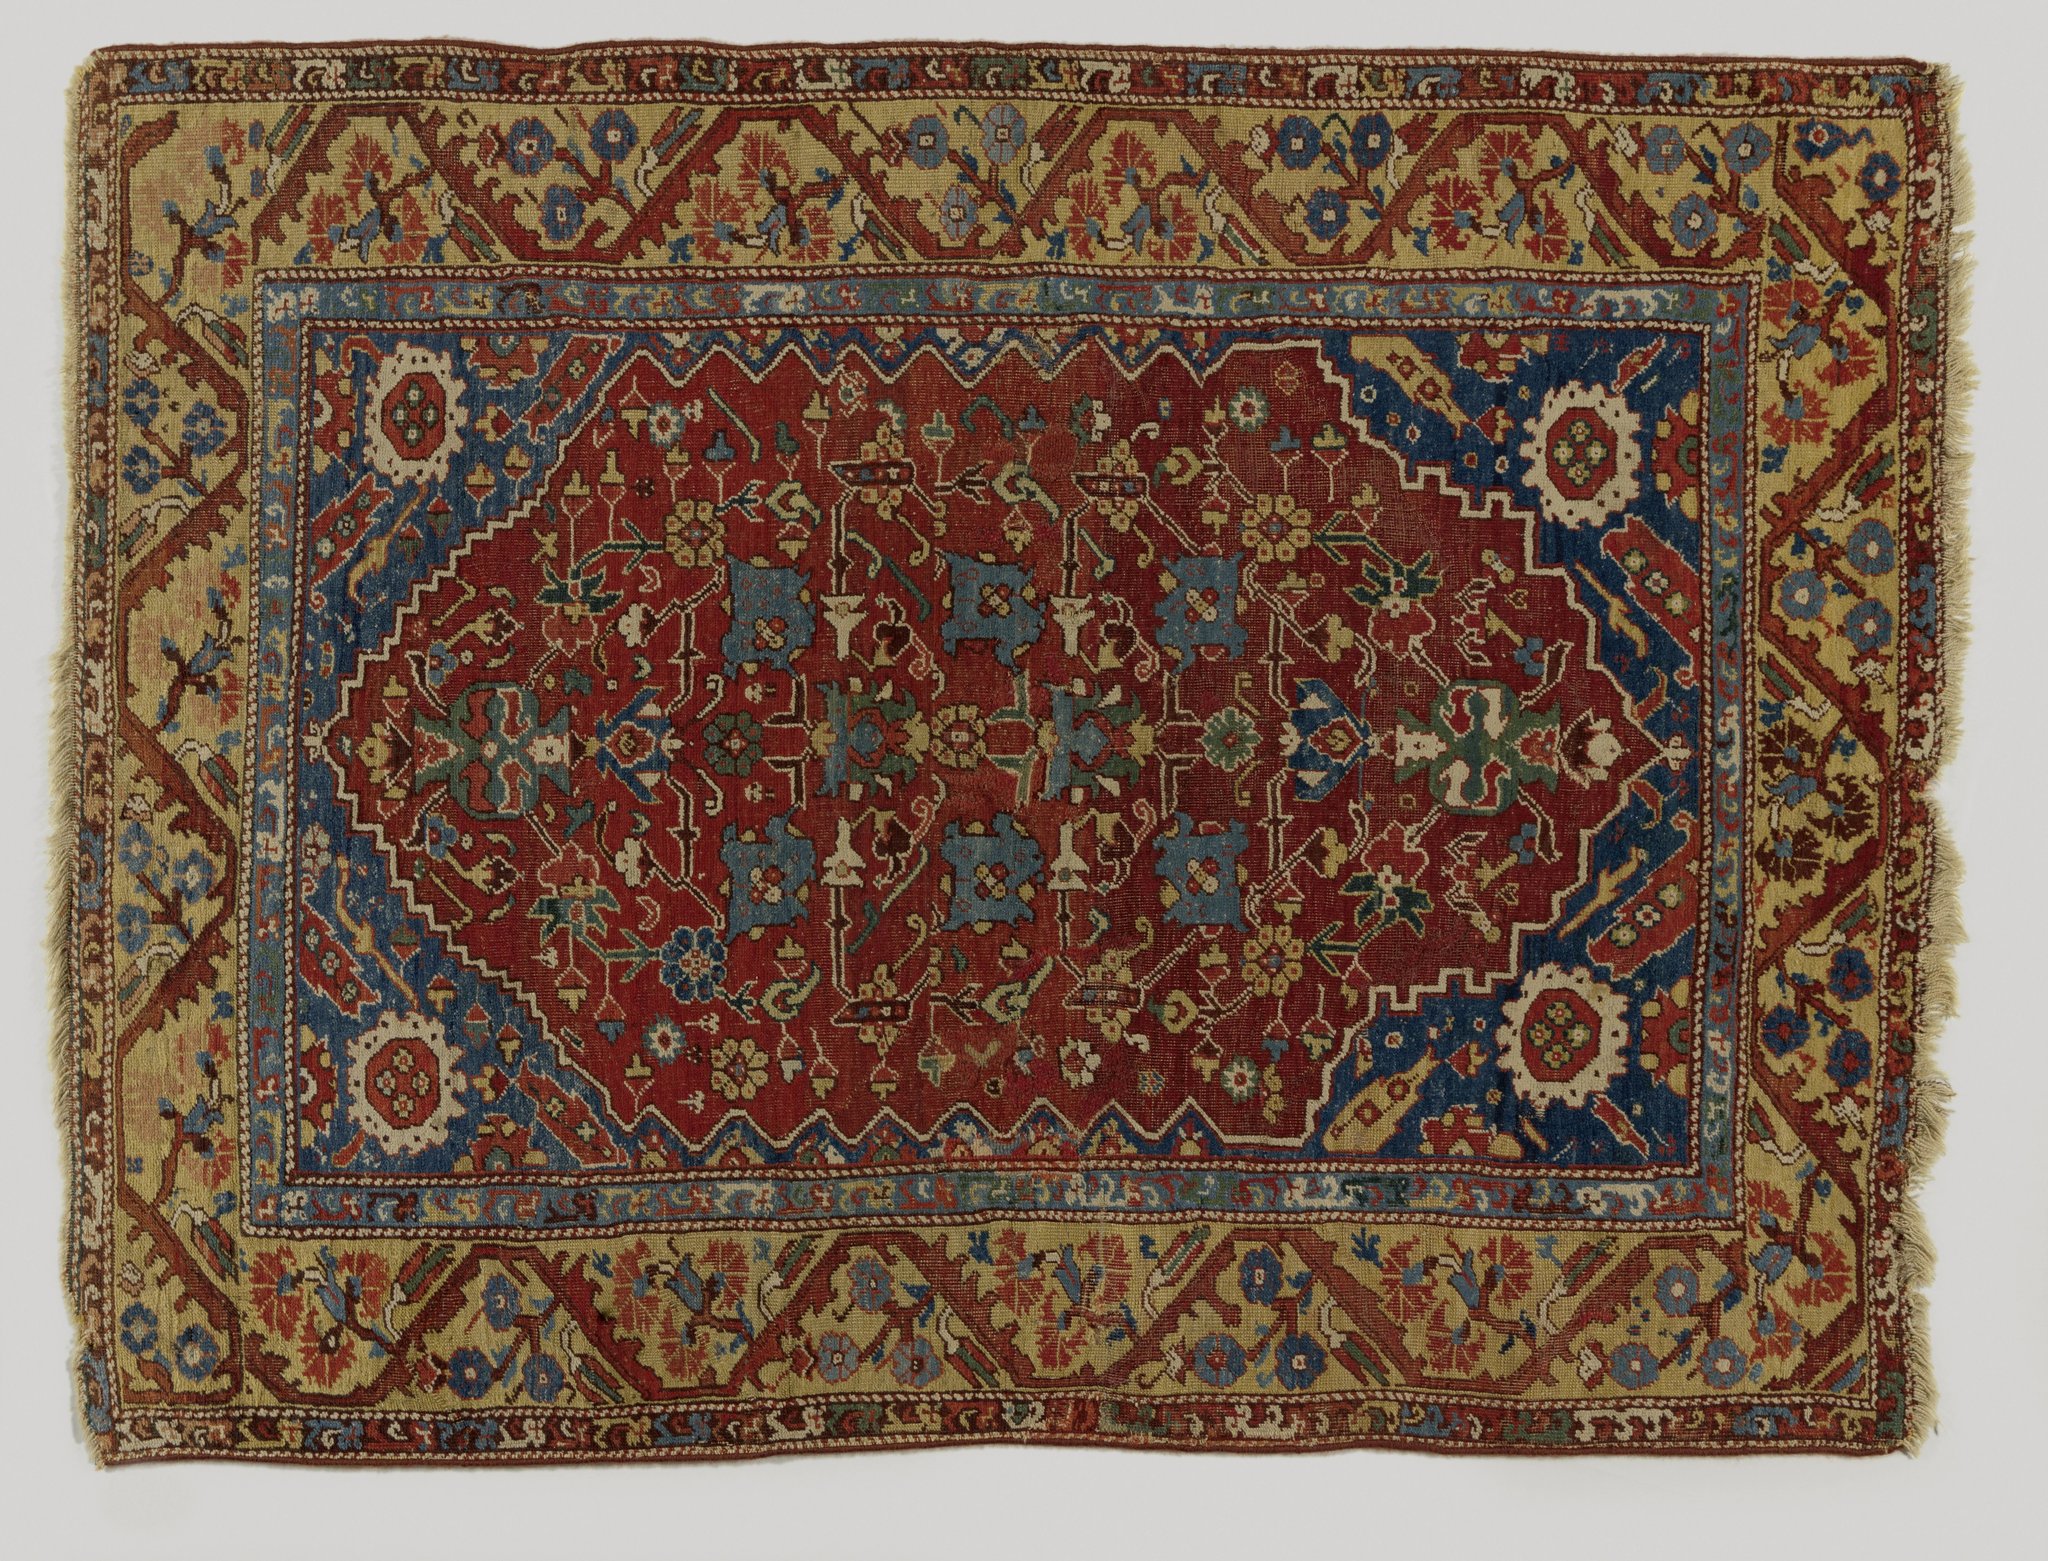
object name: tapijt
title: Bidkleed, z.g. KUMURCU-KULA, d.i. STEENKOLENKULA/VROEGER OOK 'ZEVENBURGER'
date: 1790-1810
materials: wool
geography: kula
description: Bidkleed, z.g. KUMURCU-KULA, d.i. STEENKOLENKULA/VROEGER OOK 'ZEVENBURGER'. Middenveld: dubbele mihrab in terracotta met verschillende trapgeveltoppen en zigzaglijnen aan de zijkanten. In elke top staat een groene vaas, waartussen blauwe en gele palmet- en rozetbloemen aan vertakte ranken staan. Blauwe zwikken, elk met een witte rozet en rode en gele lancetbladeren. Randen: drievoudig. De breedste is goudoker met zigzagrank in terra met om beurten een driedubbele anjer in rood en drie trosbloemen in blauw, elk vergezeld van een spitse tulp. De binnenzoom is blauw, de buitenzoom donkerbruin met gelijke voluutranken, z.g. kommarank.